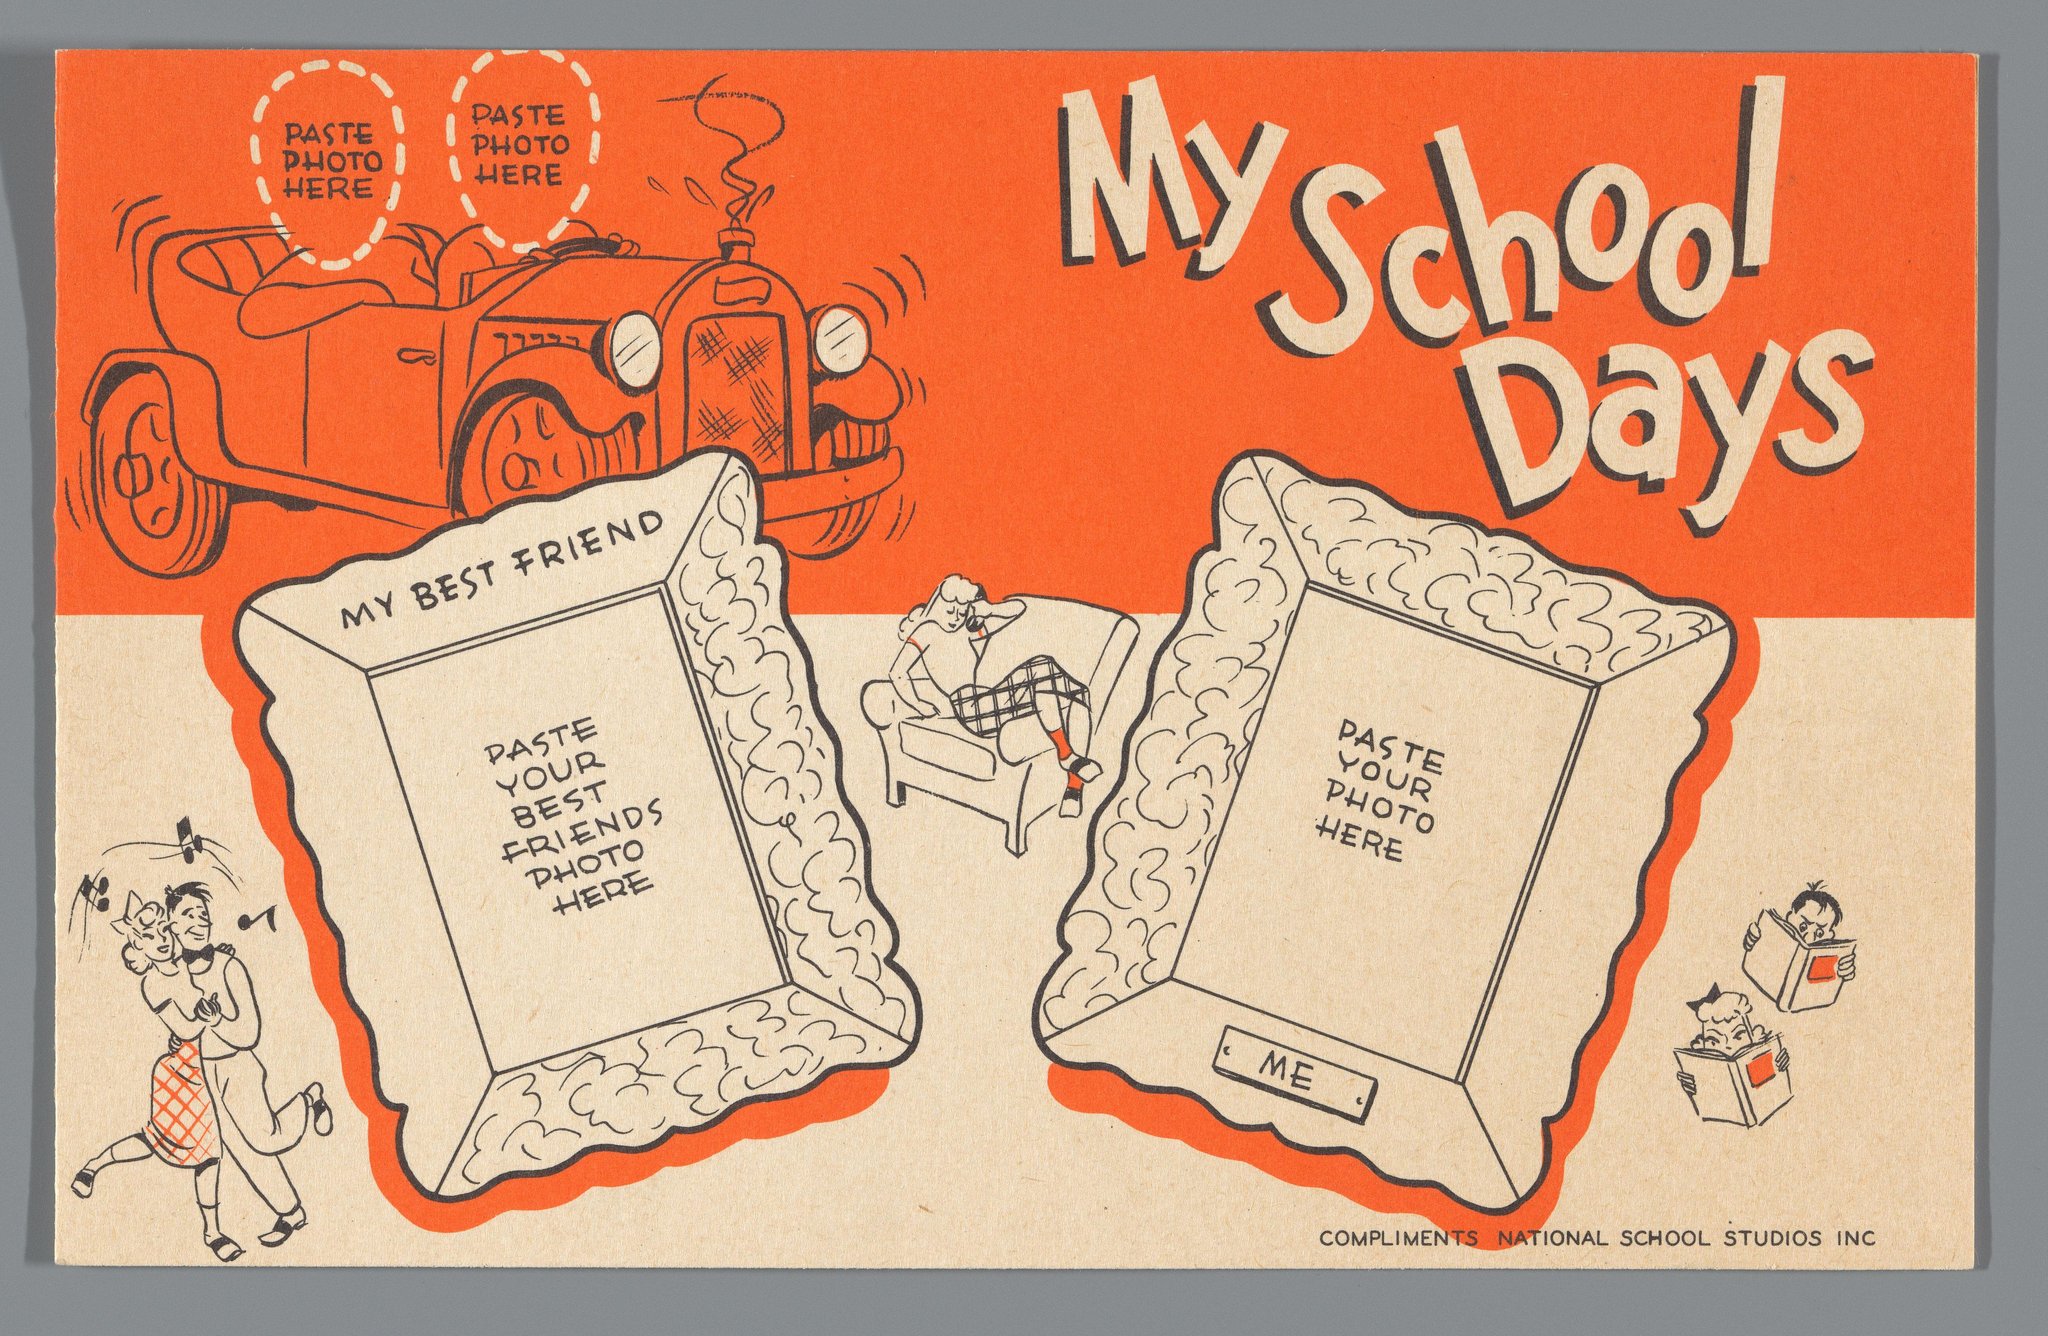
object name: photograph album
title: My schooldays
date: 1950-1960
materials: paper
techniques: printed materials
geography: minneapolis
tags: united states of america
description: Album om foto’s van vrienden en klasgenoten in op te plakken.